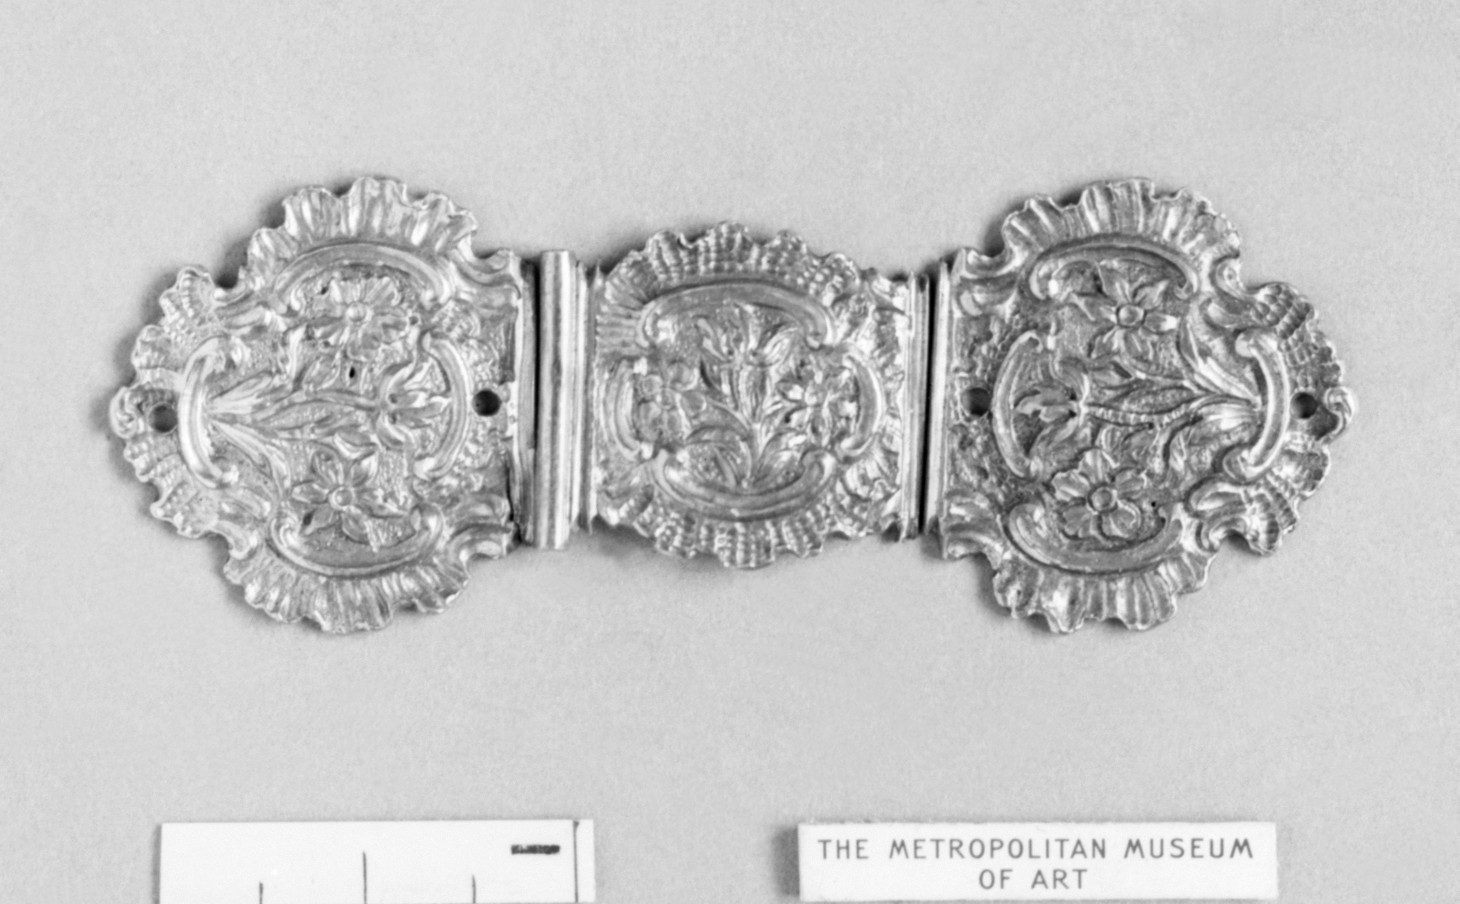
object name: book clasp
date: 1701-1800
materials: silver gilt